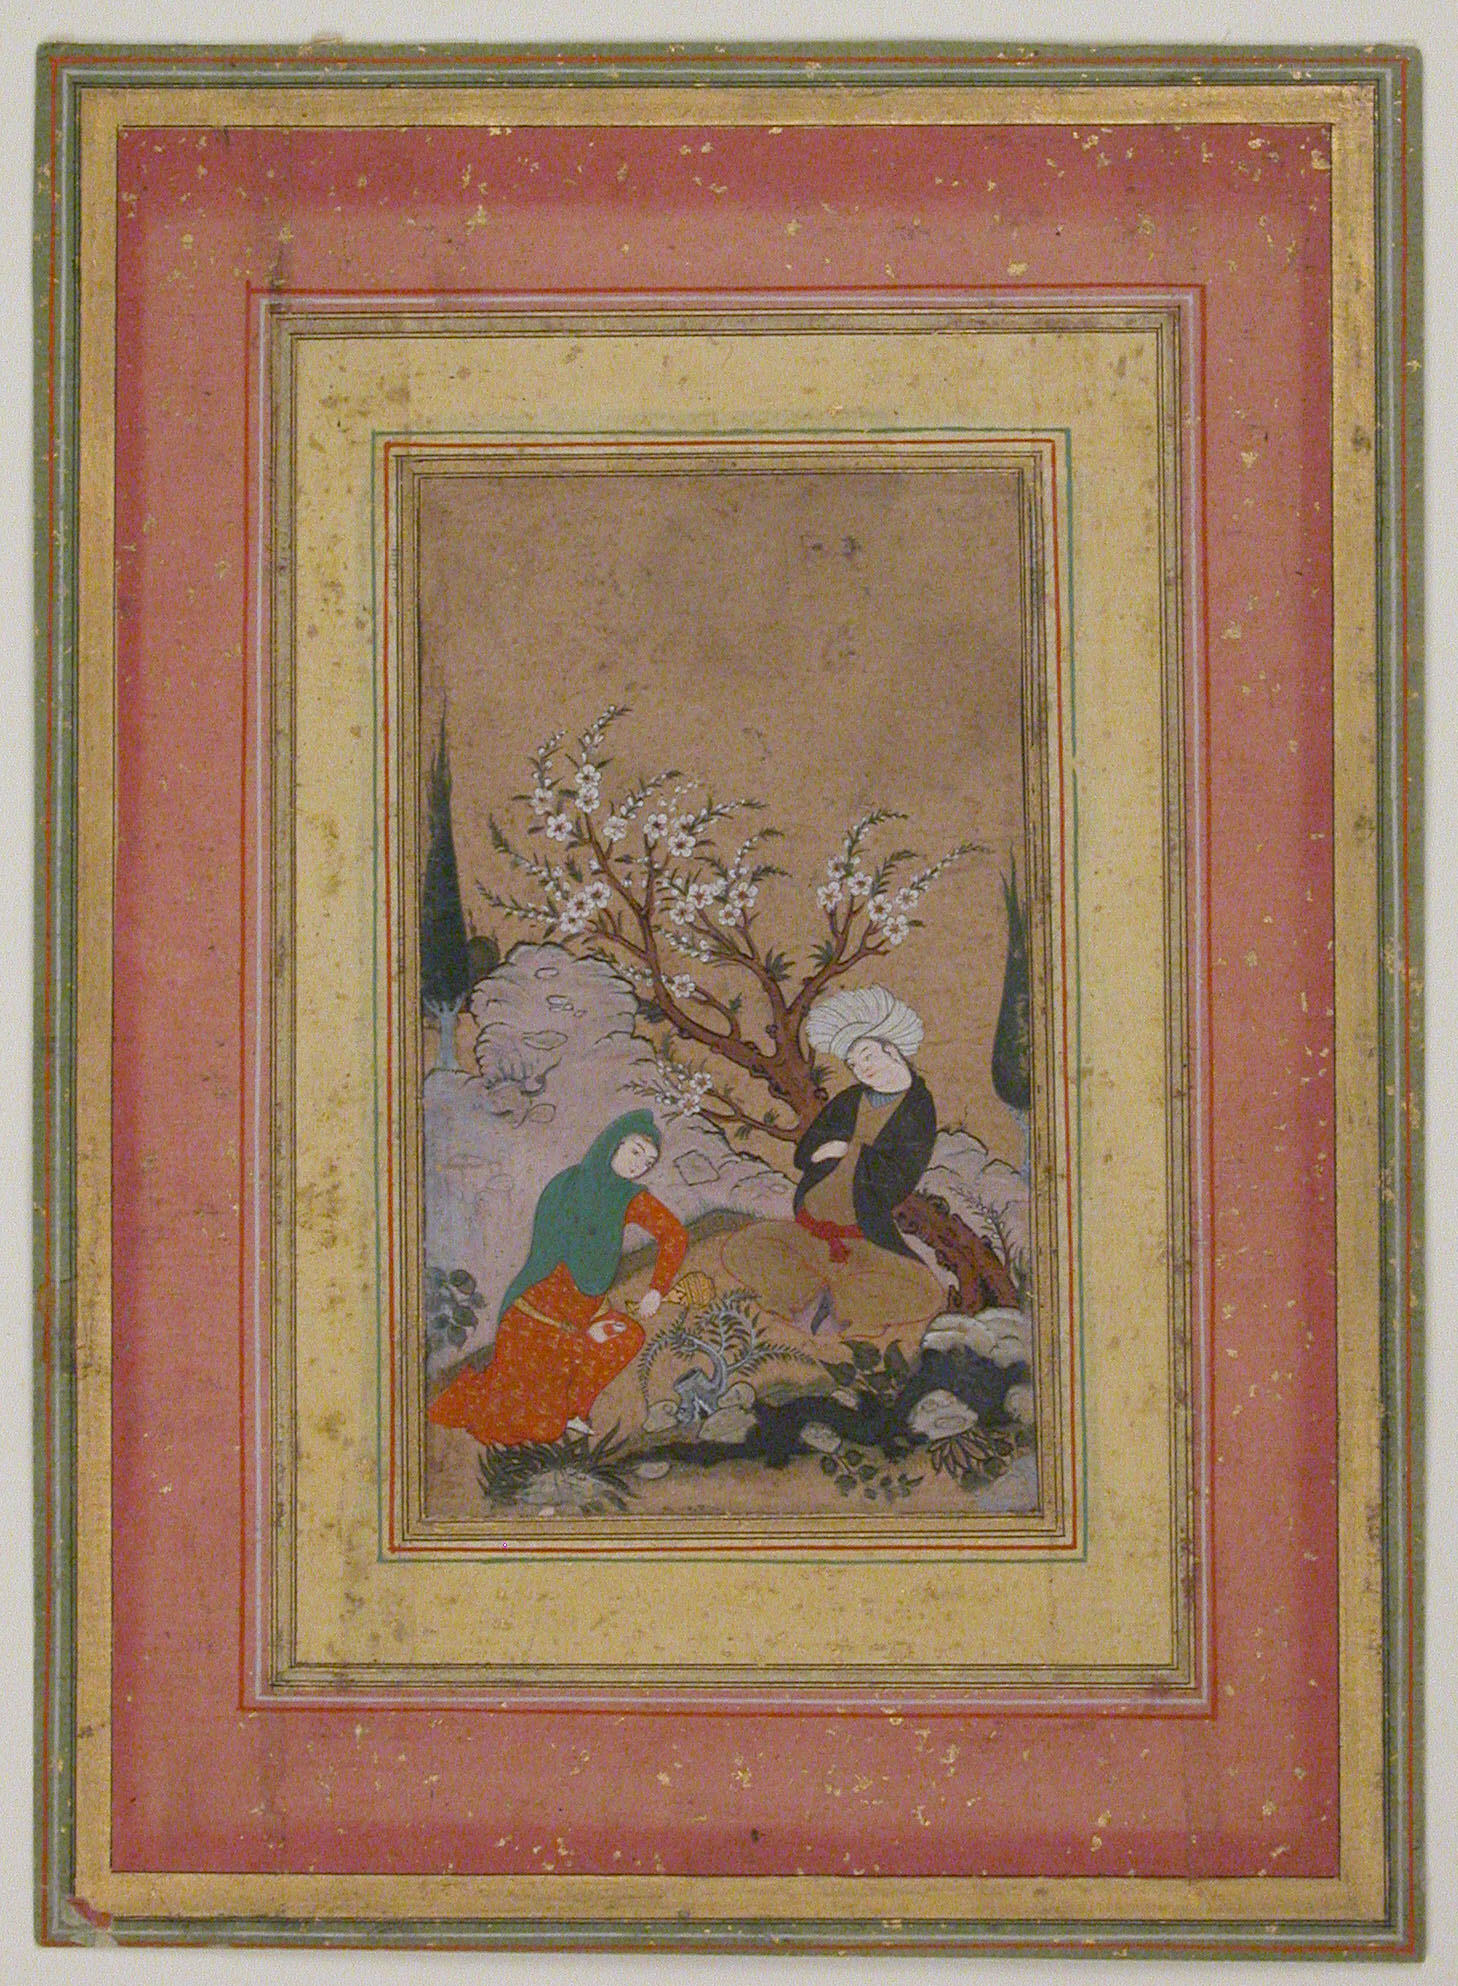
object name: folio from an illustrated manuscript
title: Love Scene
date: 1567-1633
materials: paper, watercolor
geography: iran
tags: men,women,flowers,trees